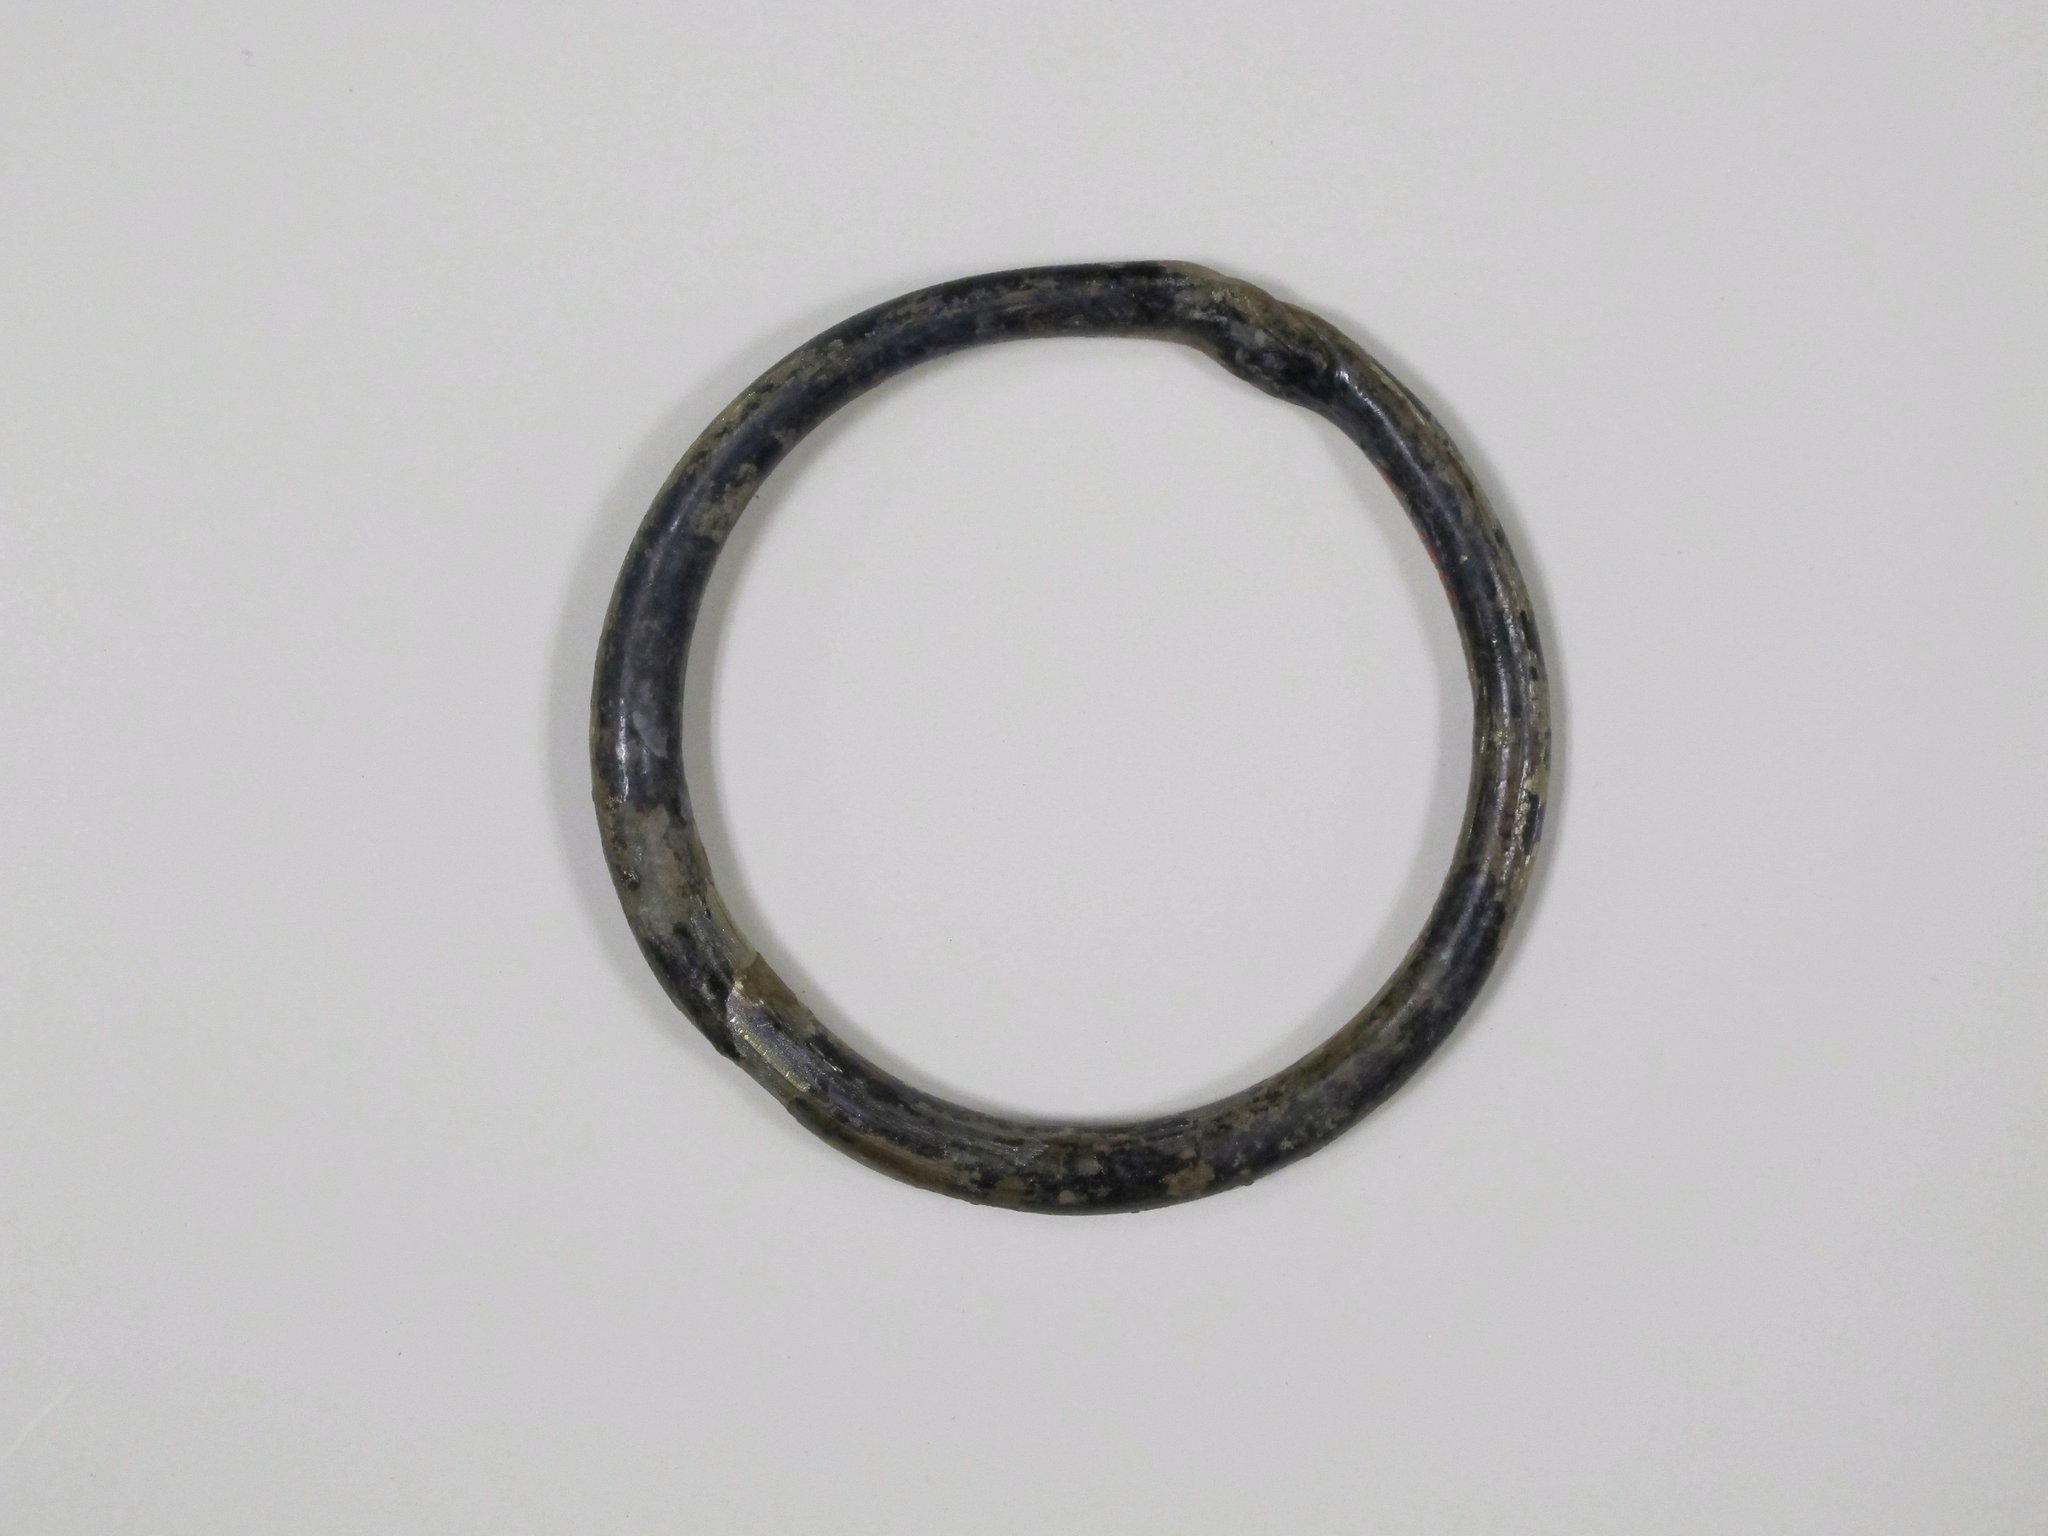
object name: bracelet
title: Glass bracelet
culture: roman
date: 101-400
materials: glass